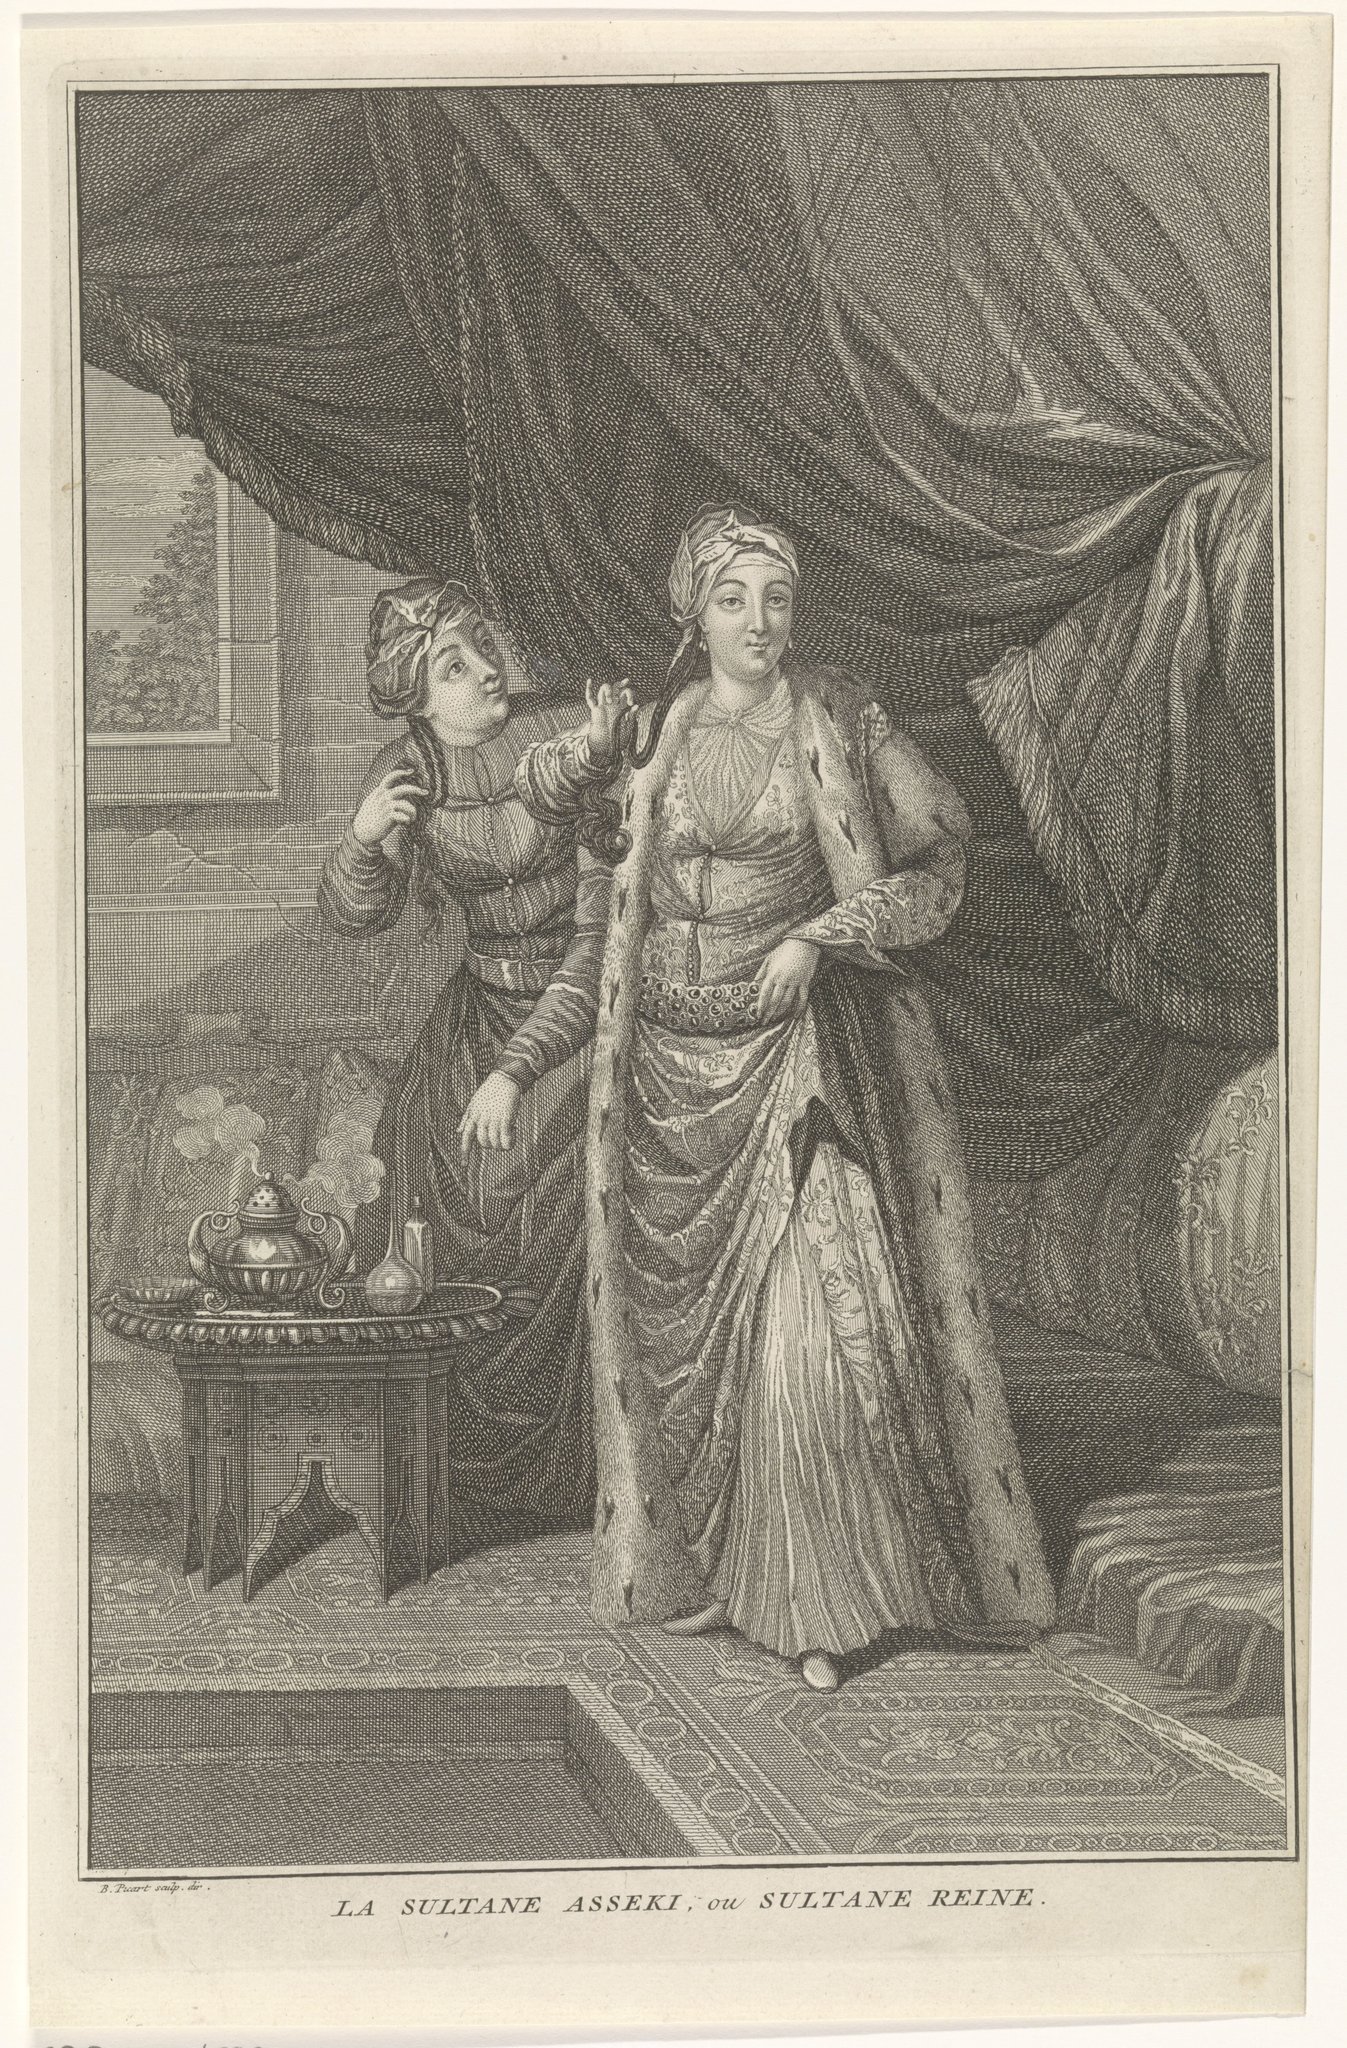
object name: costume print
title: La Sultane Asseki, ou Sultane Reine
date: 1683-1733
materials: paper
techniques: engraving, etching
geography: paris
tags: asiatic races and peoples, folk costume, regional costume, tea-pot; samovar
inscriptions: collector's mark: Lugt 2228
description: Prent als illustratie gebruikt in: Ceremonies et coutumes religieuses de tous les peuples du monde, deel VII. Amsterdam: J.F. Bernard, 1737. Zie ook: Recueil de cent estampes representant differentes nations du Levant, gravees sur les tableaux peints d'apres nature en 1707 & 1708 par l'ordre de M. de Ferriol ... et mis au jour en 1712 & 1713 par les soins de M. Le Hay. Parijs: M. de Le Hay Ferriol, 1714.